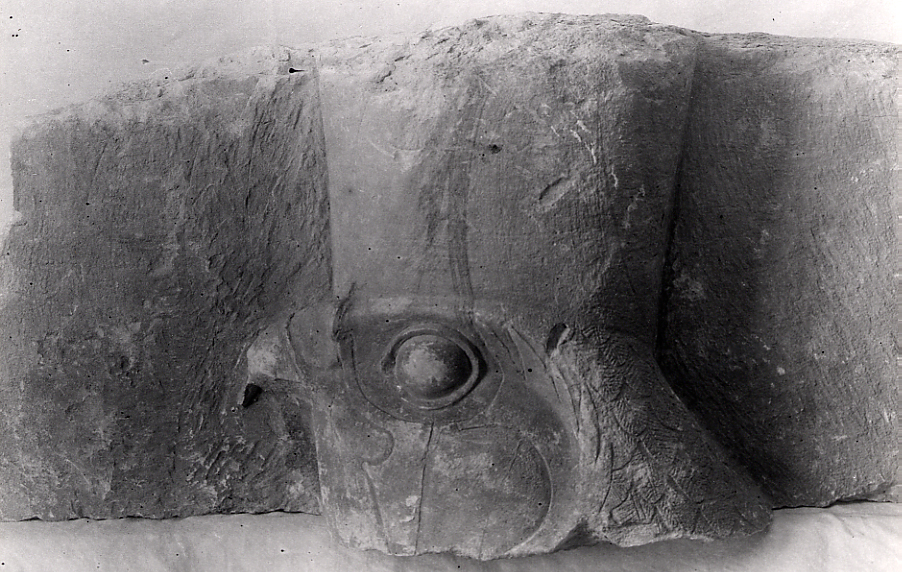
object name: relief, falcon head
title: Relief fragment from mortuary complex of Senwosret I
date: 1961-1917 BCE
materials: limestone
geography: egypt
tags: falcons